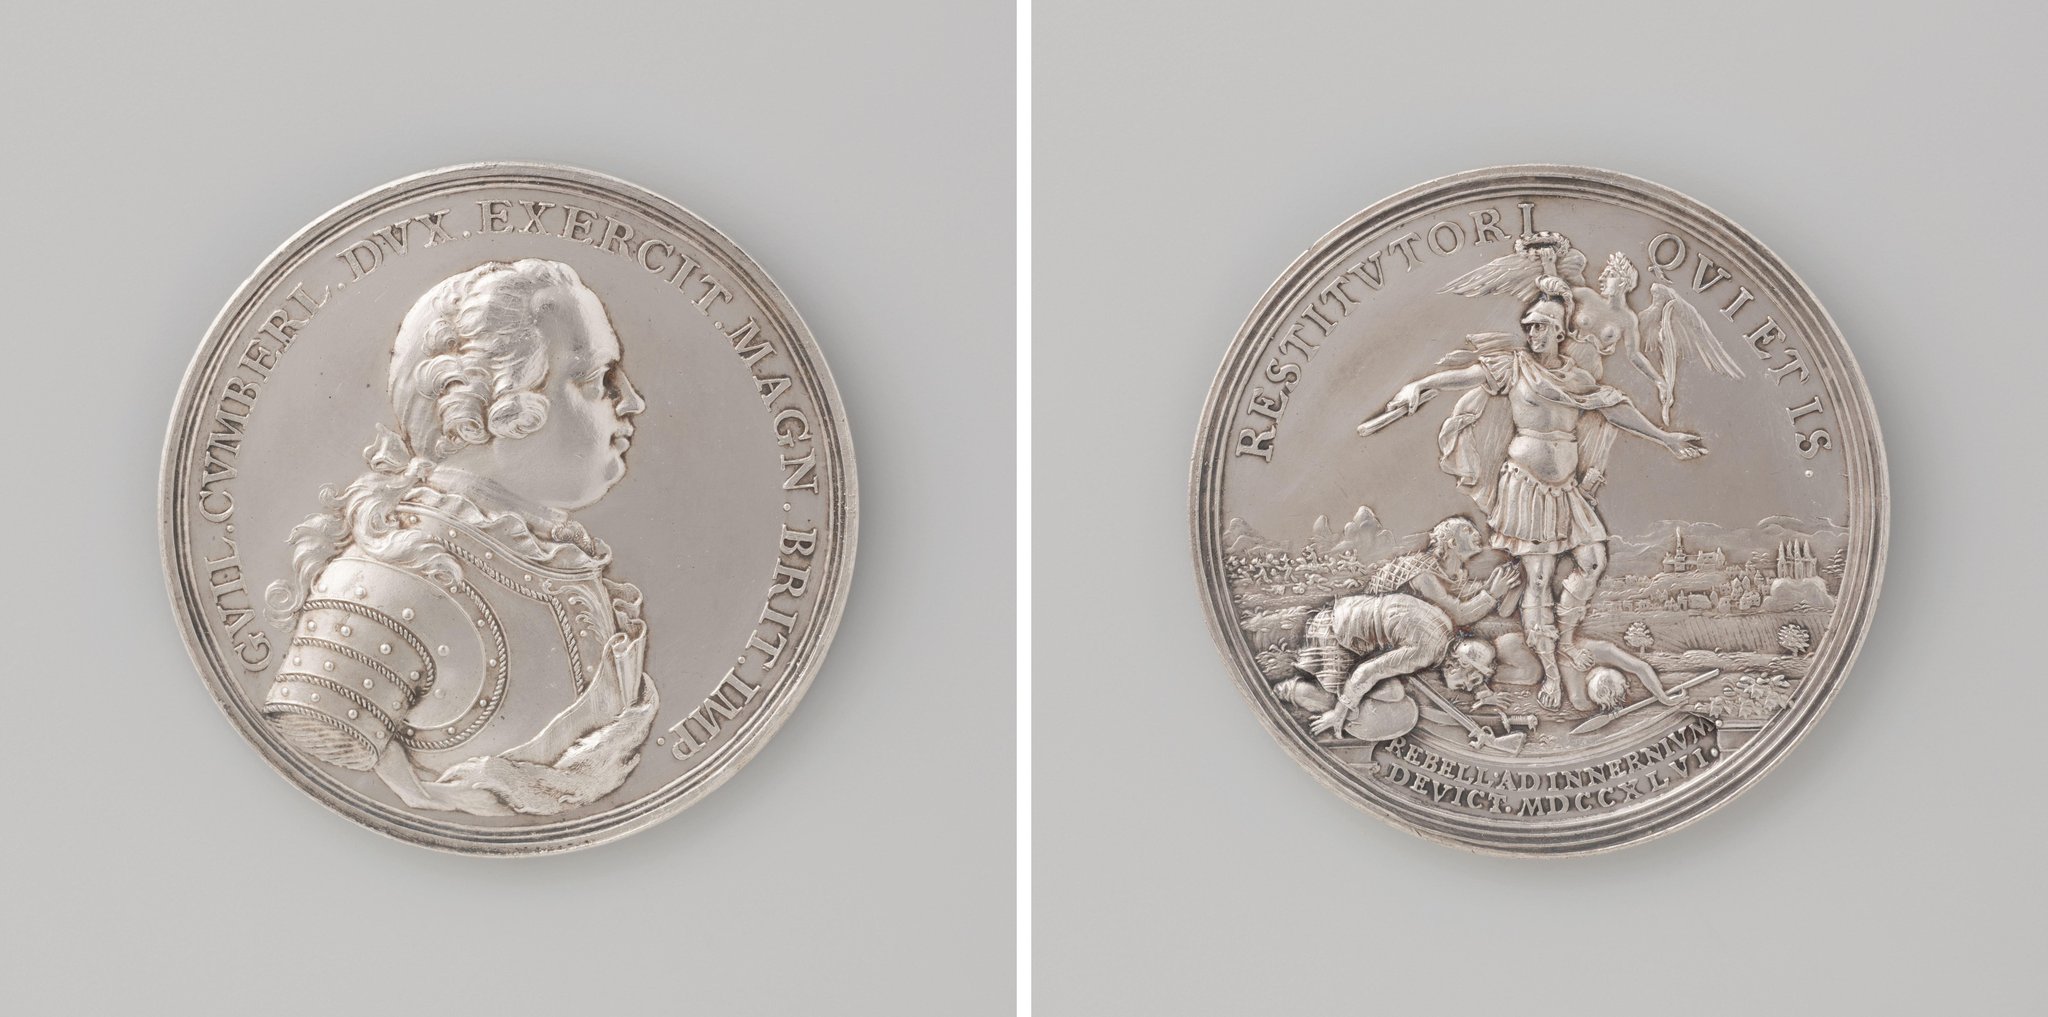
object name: history medal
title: Slag bij Culloden, ter ere van Willem, hertog van Cumberland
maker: martinus holtzhey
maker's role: medailleur, muntmaker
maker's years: 1697-1764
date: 1746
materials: silver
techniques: striking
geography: amsterdam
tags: prins, admiraal, willem van cumberland (hertog), culloden, inverness, schotse opstand, slag bij culloden